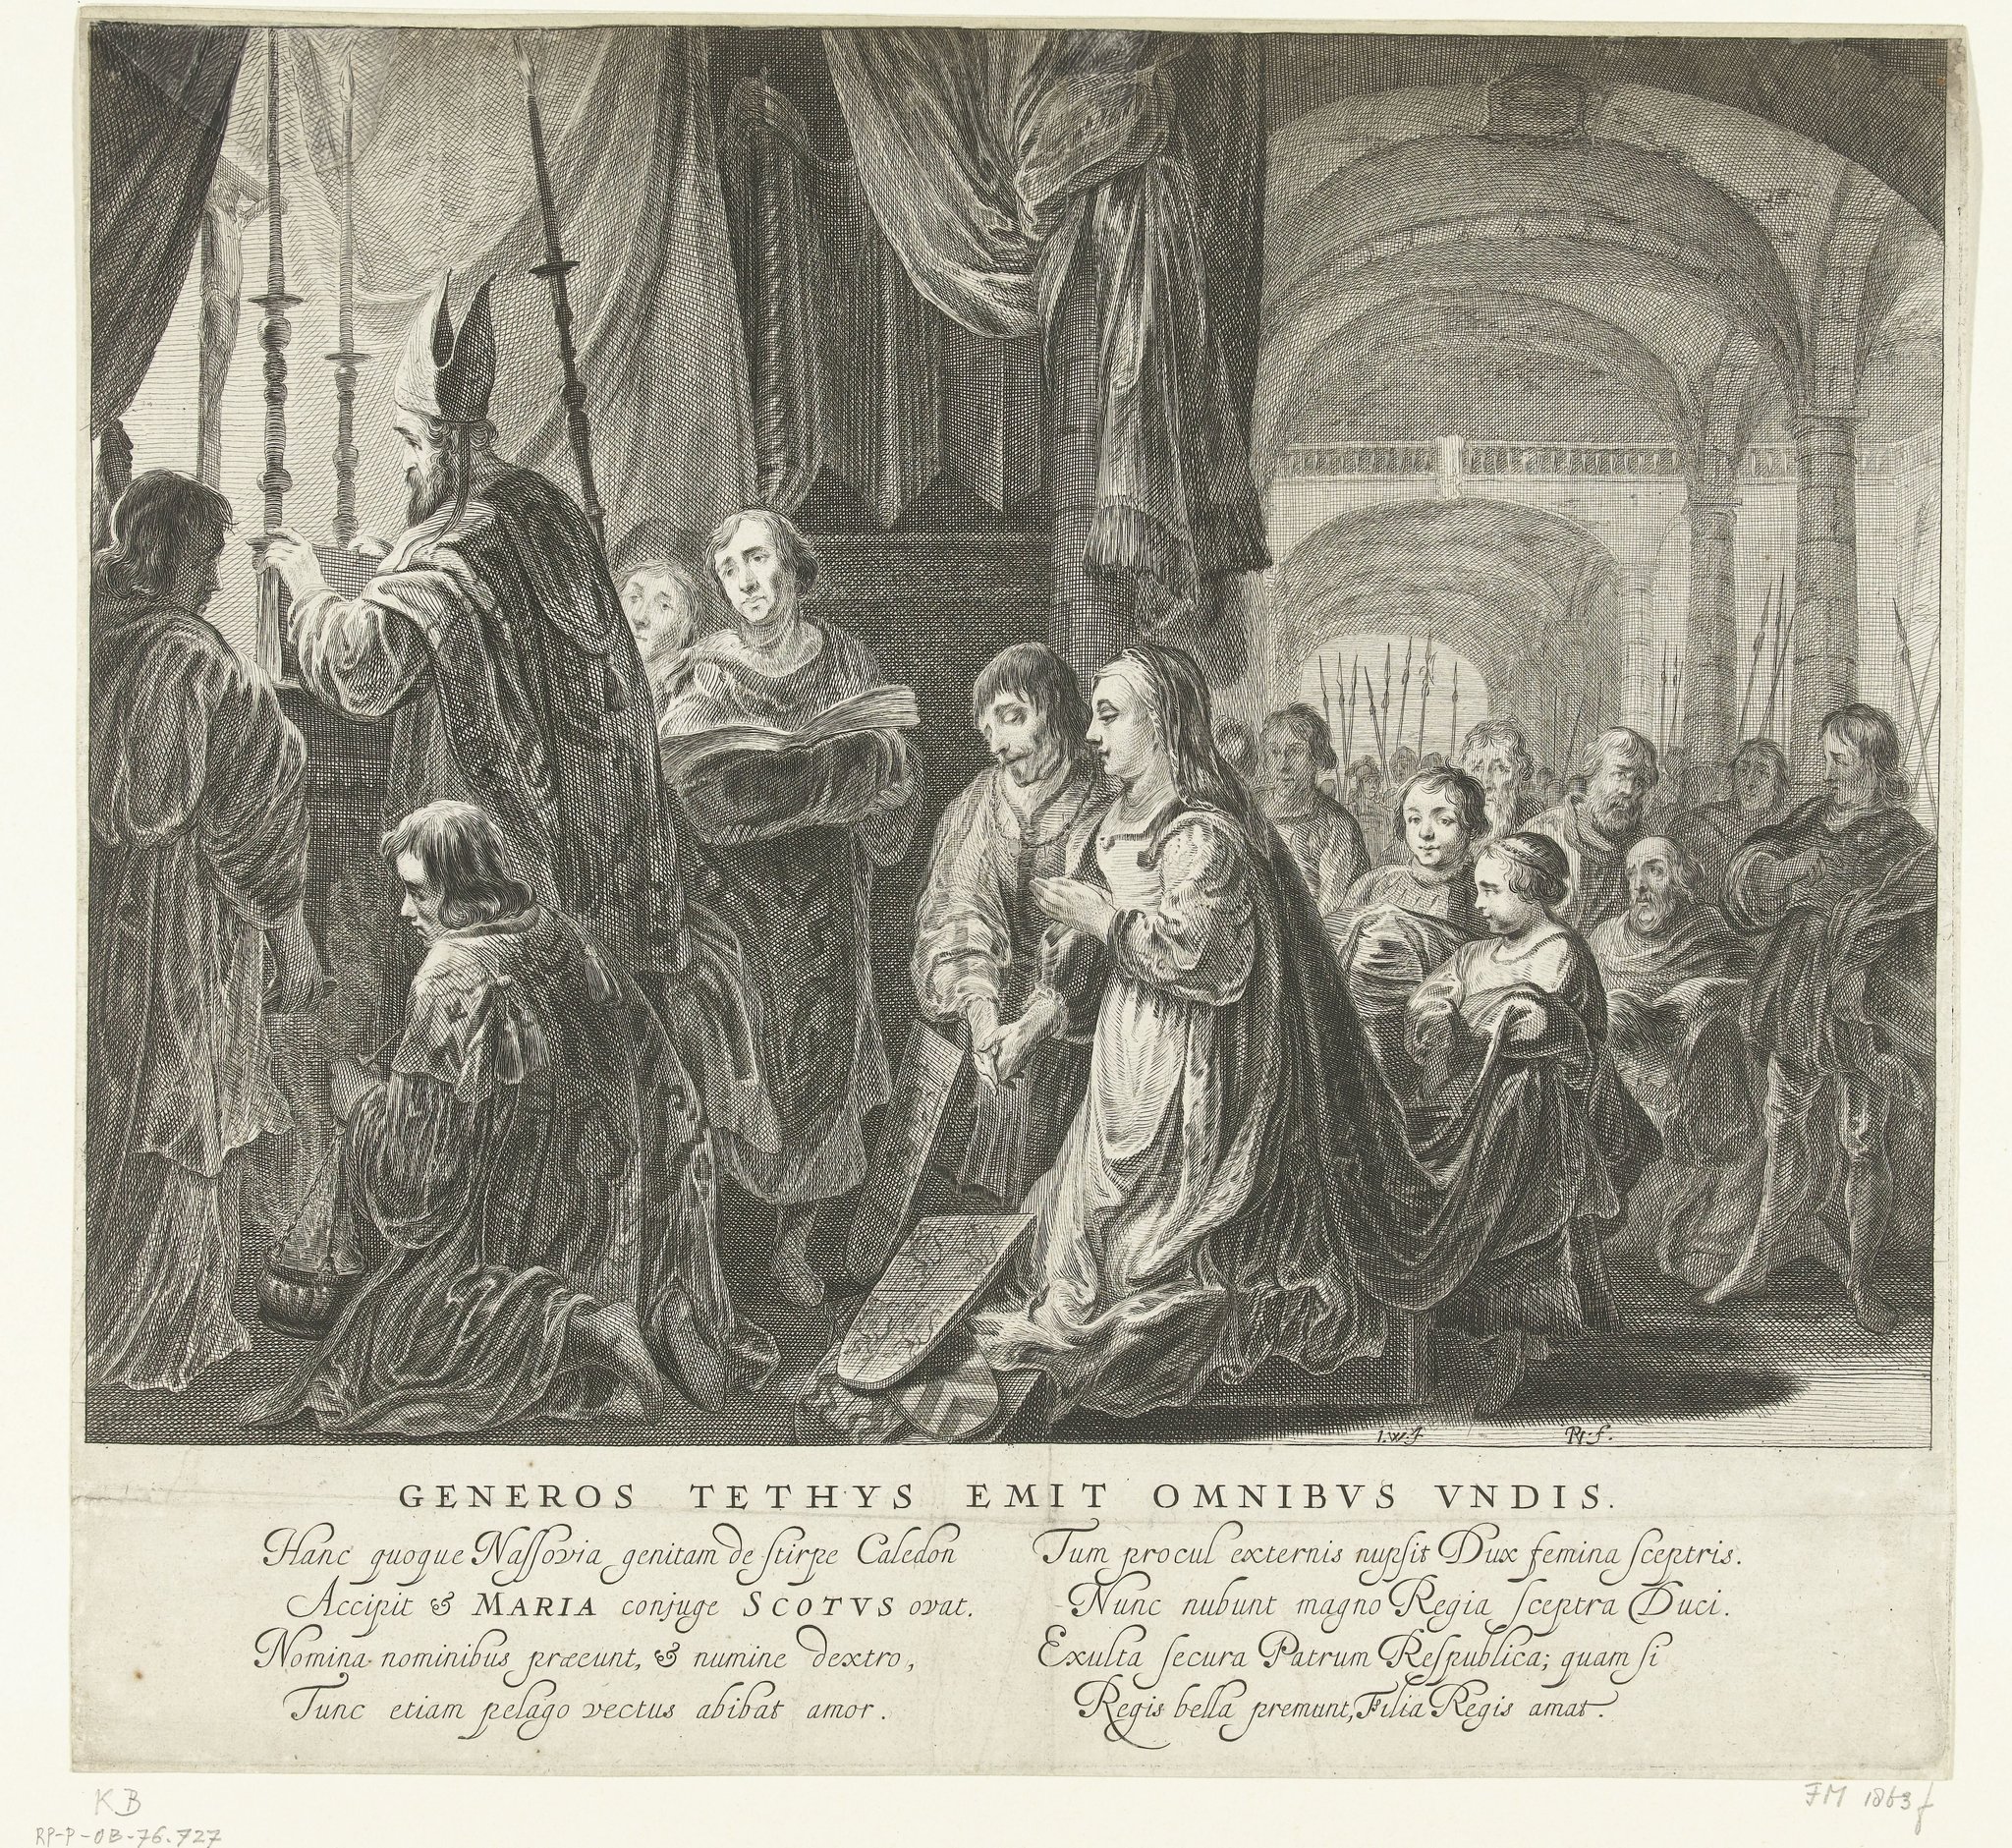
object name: print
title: Tableau vivant met het huwelijk van Jacobus II van Schotland met Maria van Gelre-Egmond in 1449, 1642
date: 1642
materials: paper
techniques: engraving, etching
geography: northern netherlands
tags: henriëtta maria van frankrijk (koningin van engeland, schotland en ierland), 'tableau vivant', triumphal entry and public reception, pageant, 'entrée solennelle', 'joyeuse entrée', (civil) marriage ceremonies, amsterdam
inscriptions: collector's mark: Lugt 240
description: Allegorisch tableau vivant met het huwelijk van koning Jacobus II van Schotland met Maria van Gelre-Egmond in 1449. Vertoning in de theaterpoort opgericht op de Varkenssluis voor de Doelenstraat bij het bezoek van Engelse koningin Henrietta Maria aan Amsterdam, 20-22 mei 1642. In het onderschrift de titel en 2 keer 4 regels in het Latijn. Zesde plaat in een groep van tien vertoningen en triomfbogen.